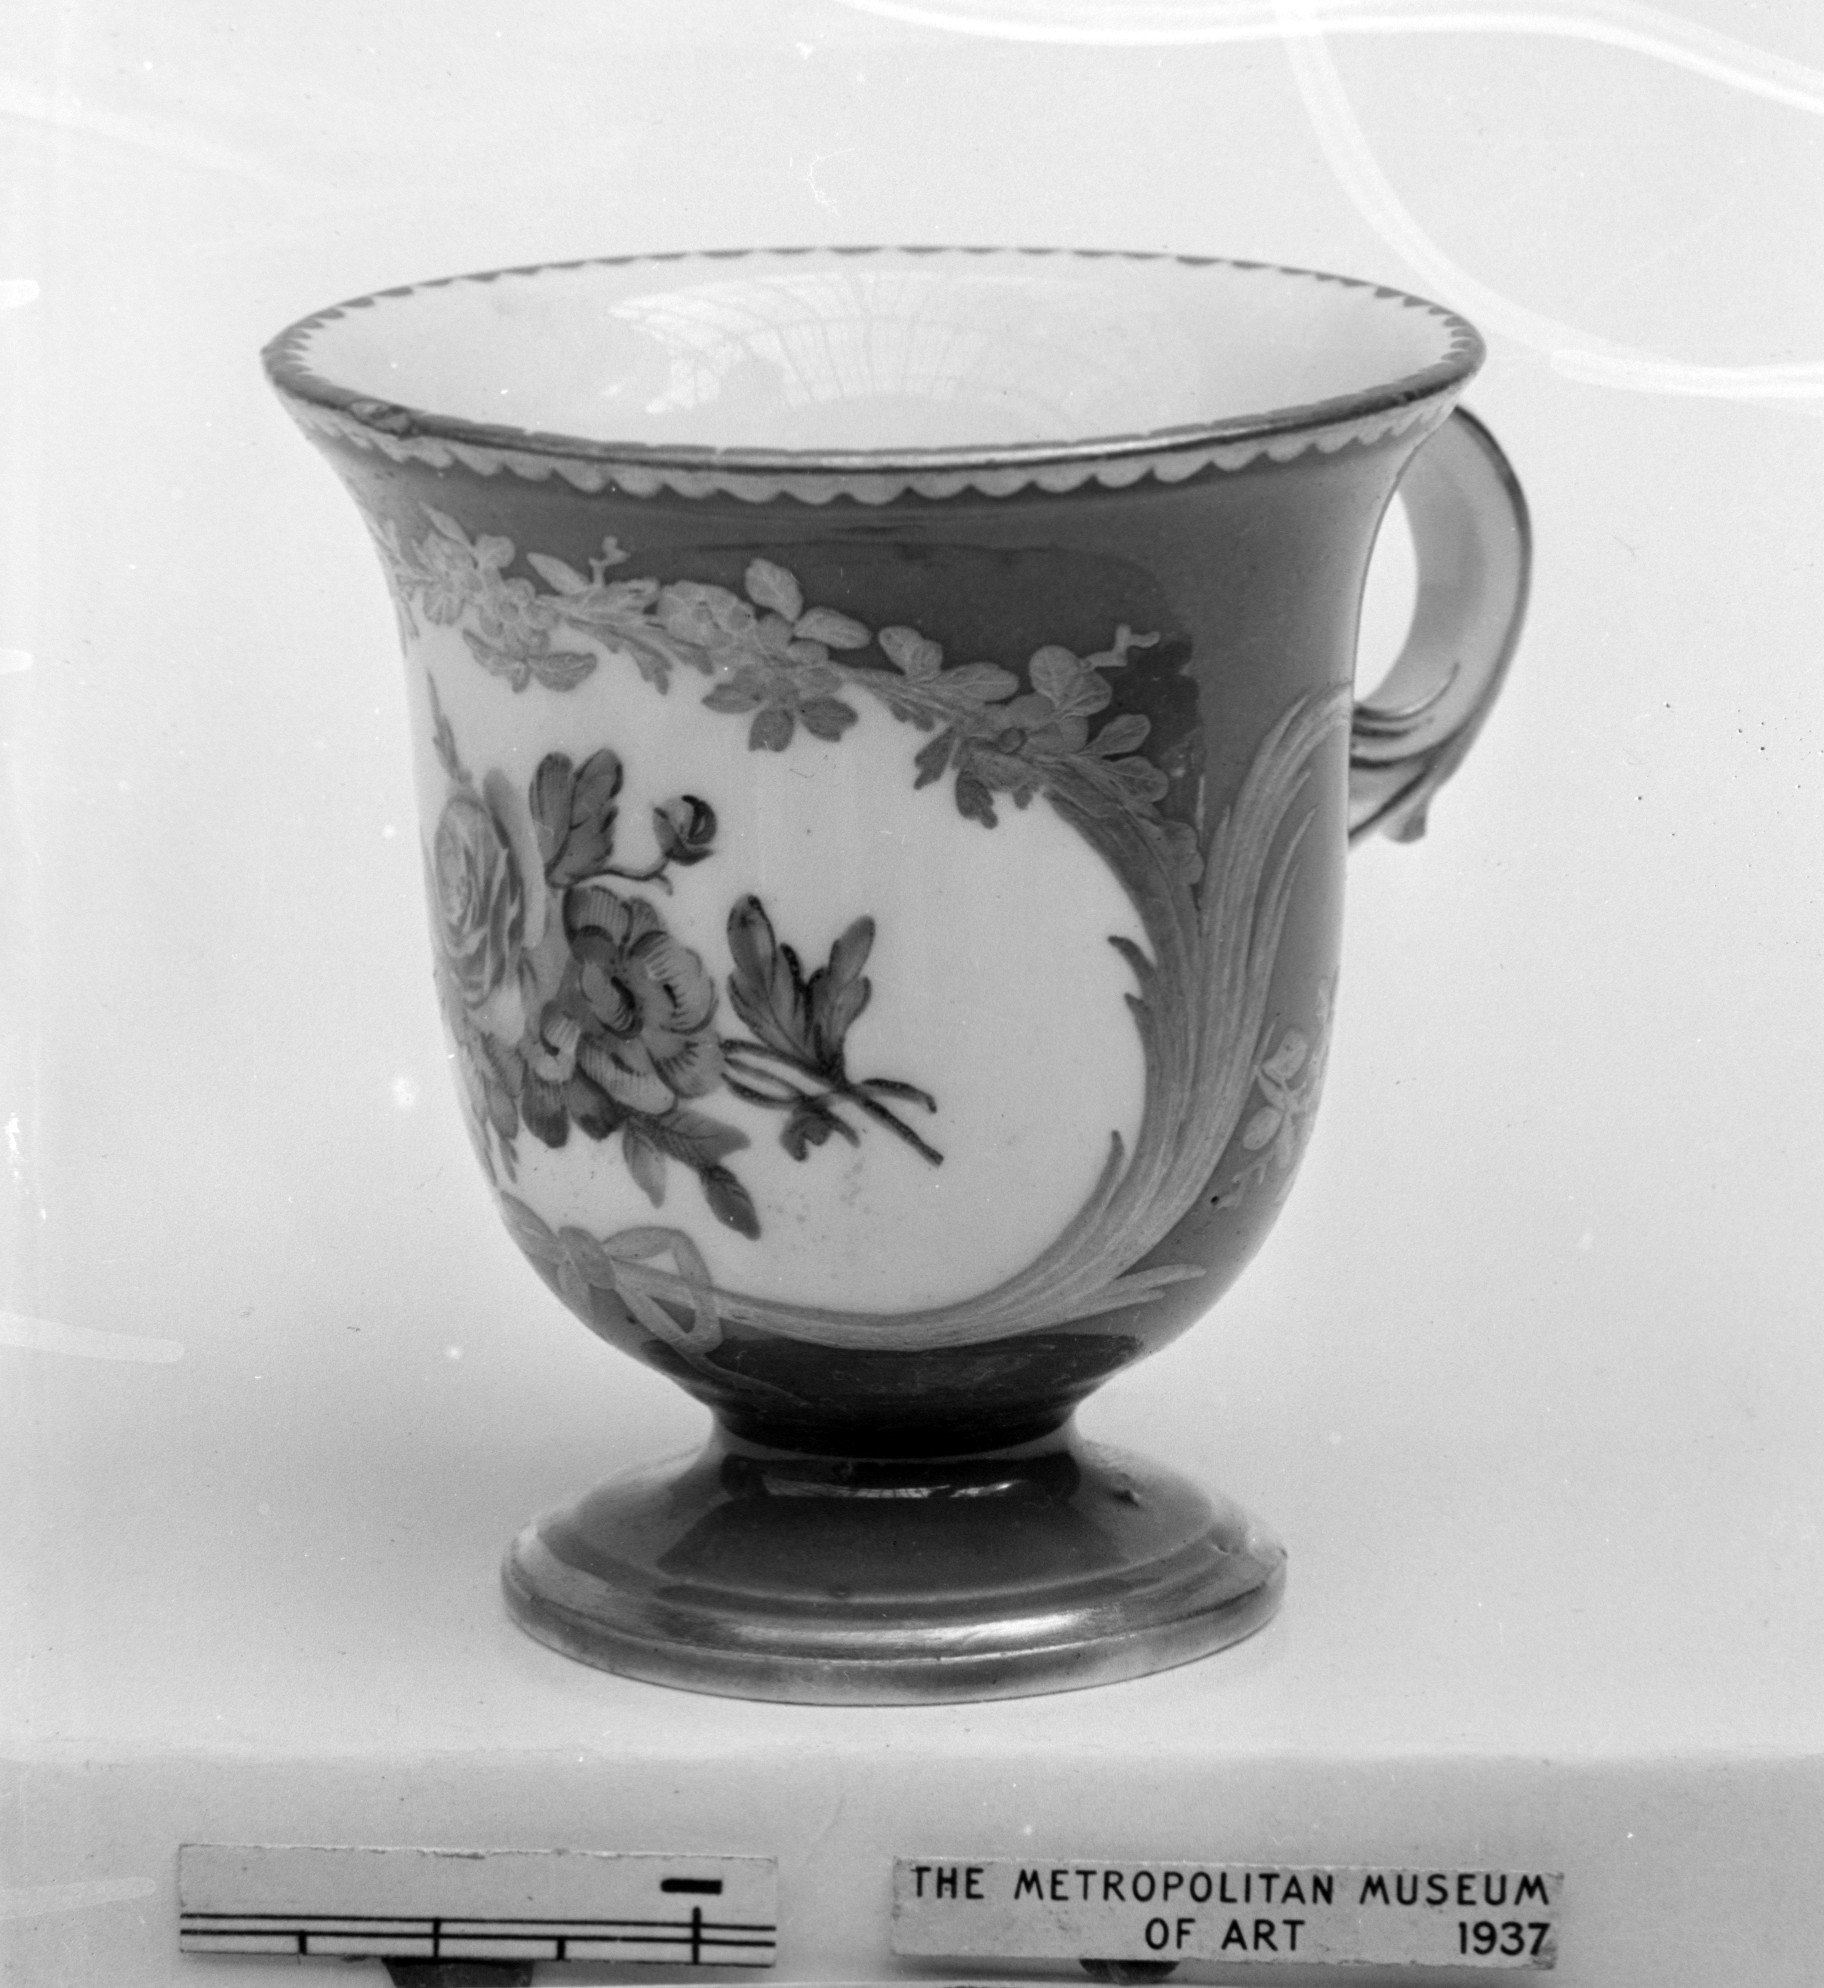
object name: ice cream cup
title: Ice cream cup (Tasse à glace) (part of a service)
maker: sèvres manufactory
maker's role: manufactory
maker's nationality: french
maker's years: 1740-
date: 1780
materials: soft paste porcelain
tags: flowers